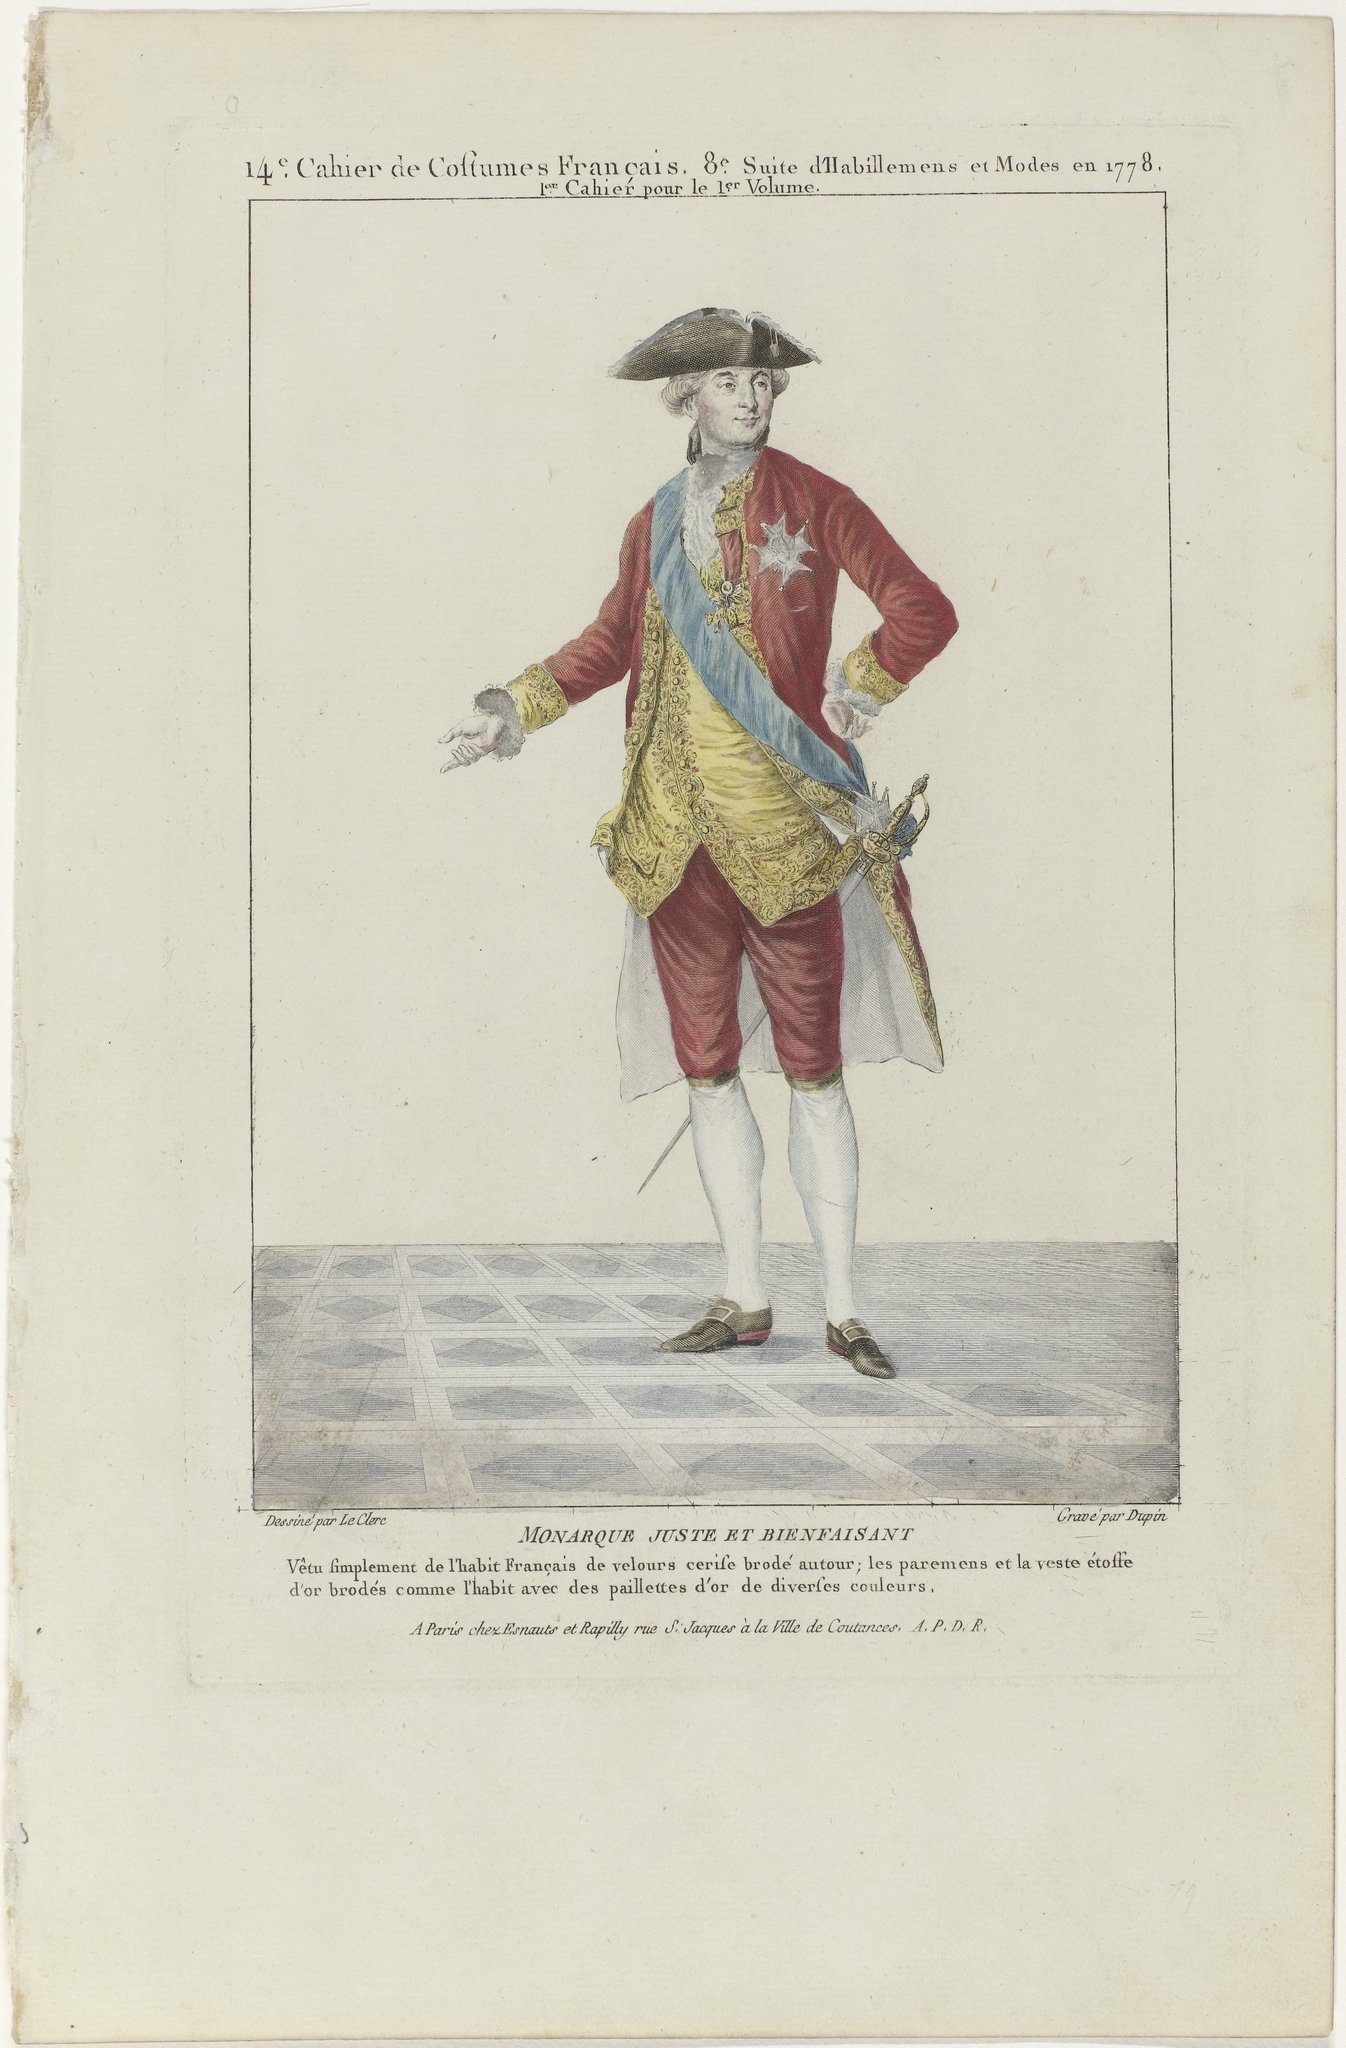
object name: fashion print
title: Gallerie des Modes et Costumes Français, 1778, O 79 : Monarque juste et Bienfaisant (...)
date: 1778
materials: paper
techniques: engraving, hand coloring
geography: paris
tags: head-gear: tricorn (+ men's clothes), clothing for the upper part of the body (vest) (+ men's clothes), ensembles of pieces of clothing (habit à la française) (+ men's clothes), fashion plates, shoes, sandals (+ men's clothes), trousers, breeches, etc. (breeches) (+ men's clothes), stockings, socks (+ men's clothes), sleeves (+ men's clothes), king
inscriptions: inscription: ‘14e Cahier de Costumes Français.8e Suite d'Habillemens et Modes en 1778. 1er. Cahier pour le 1er Volume.’, address: ‘A Paris chez Esnauts et Rapilly rue S. Jacques à la Ville de Coutances.A.P.D.R.’, title: ‘Monarque juste et bienfaisant’, caption: ‘Vêtu simplement de l'habit Français de velours cerise brodé autour; les paremens et la veste étoffe d'or brodés comme l'habit avec des paillettes d'or de diverses couleurs.’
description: Lodewijk XVI als rechtvaardig en weldoend vorst, gekleed in een 'habit à la Française' van kersenrood fluweel versierd met borduurwerk. De manchetten en het vest zijn van goudkleurige stof en op dezelfde manier geborduurd als de jas met pailletten van verschillende kleuren goud. Blauwe sjerp en op de borst het kruis van de koninklijke en militaire Orde van de H. Lodewijk. Verdere accessoires: driekantige steek met knoop en lis, (sier)degen, schoenen met rode hakken en gespen. Prent uit serie O. 14e Cahier de Costumes Français, 8e Suite d'Habillemens à la mode en 1778, Gallerie des Modes et Costumes Français.